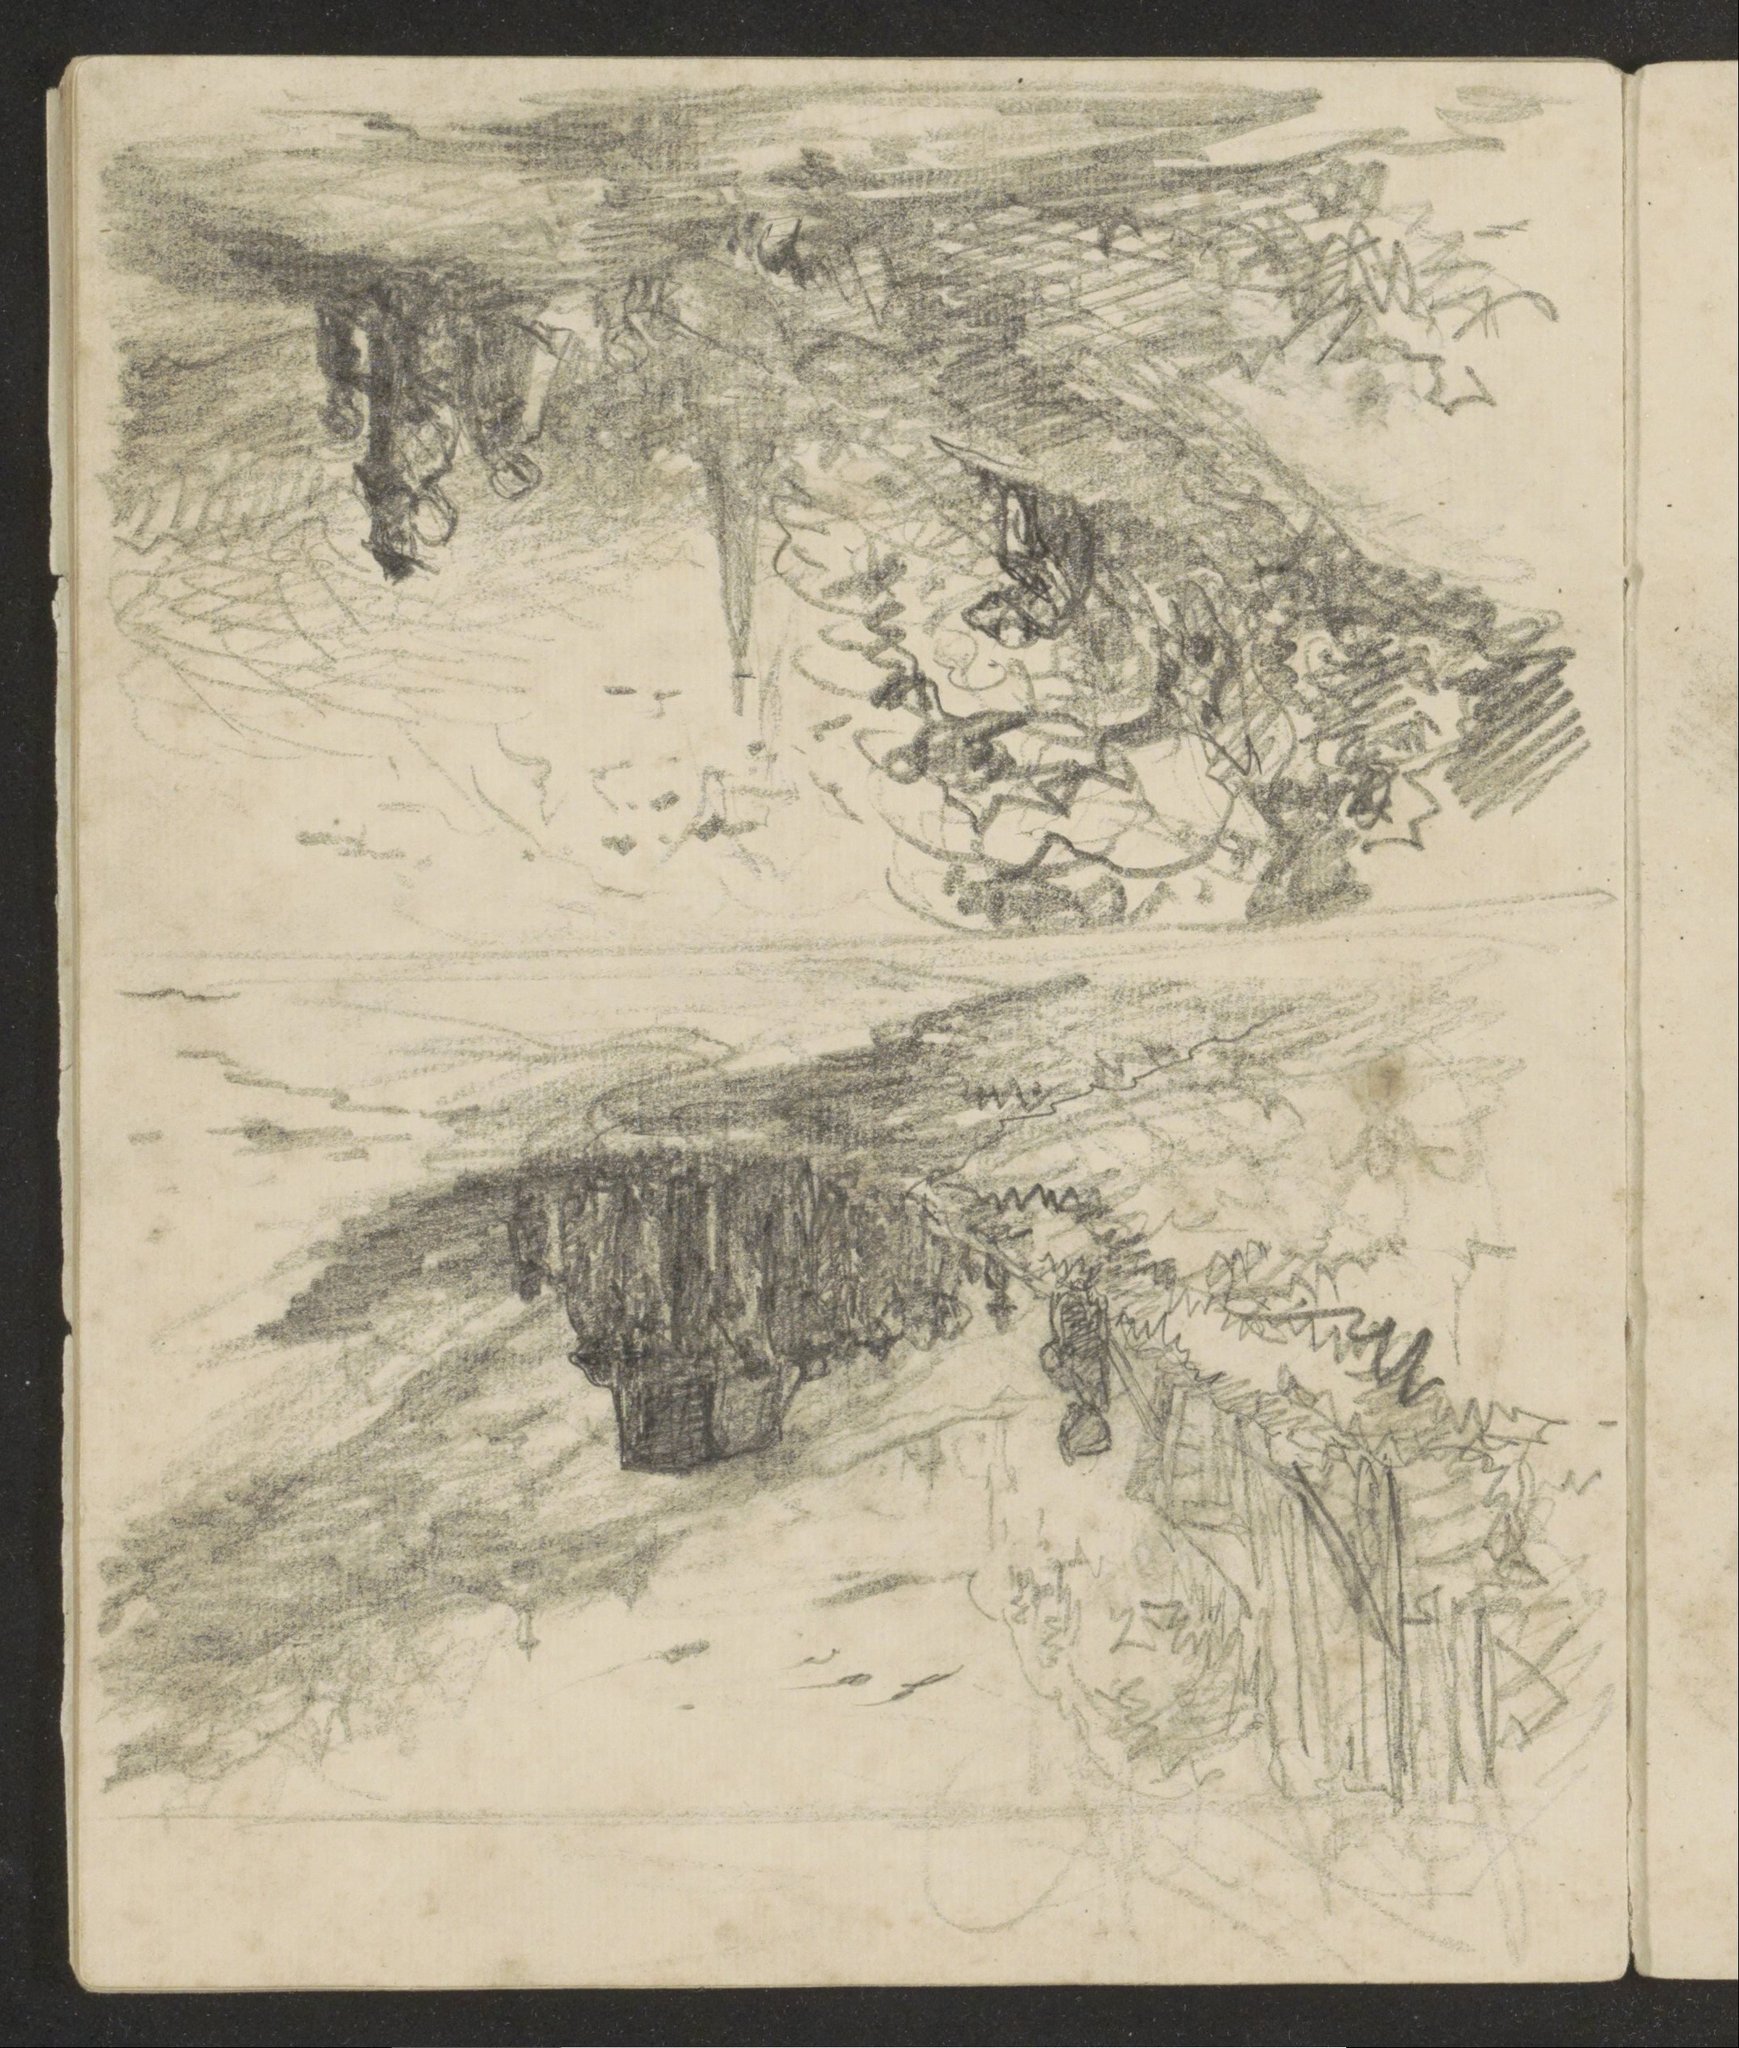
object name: sketchbook leaf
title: Landschap met een kind bij een huis aan een pad en een landschap met figuren op een pad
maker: maria vos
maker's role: draughtsman, painter, print maker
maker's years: 1824-1906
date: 1834-1906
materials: paper, pencil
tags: road, path, landscapes (+ landscape with figures, staffage)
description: Blad 19 verso uit een schetsboek met 21 bladen.